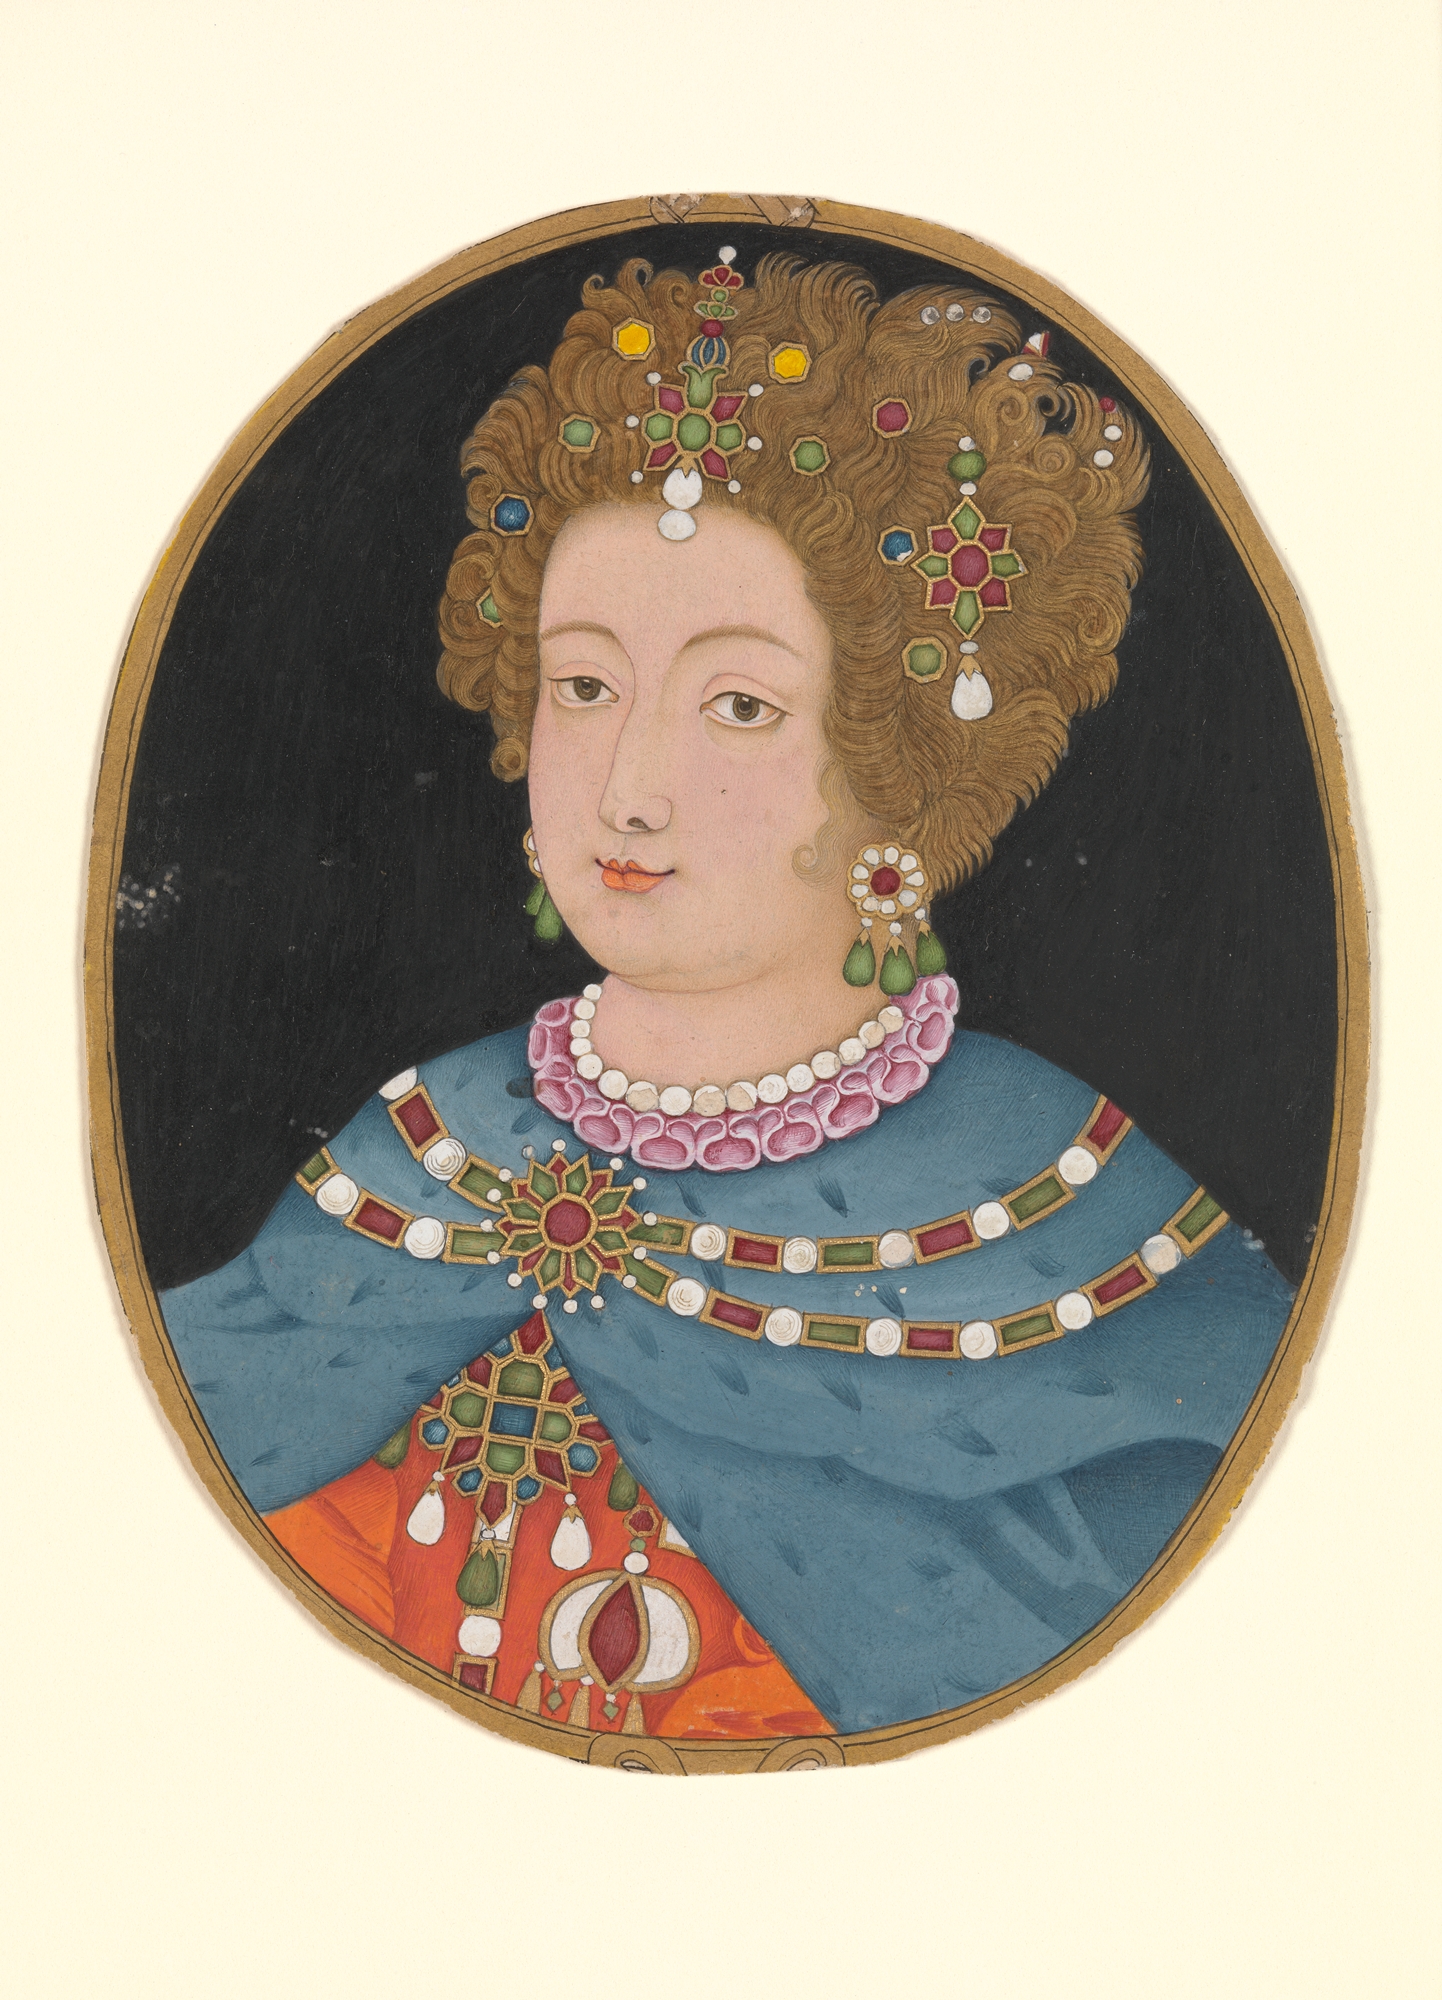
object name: painting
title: Lady in Elizabethan Costume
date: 1667-1700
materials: gold, paper, silver, watercolor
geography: india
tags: women